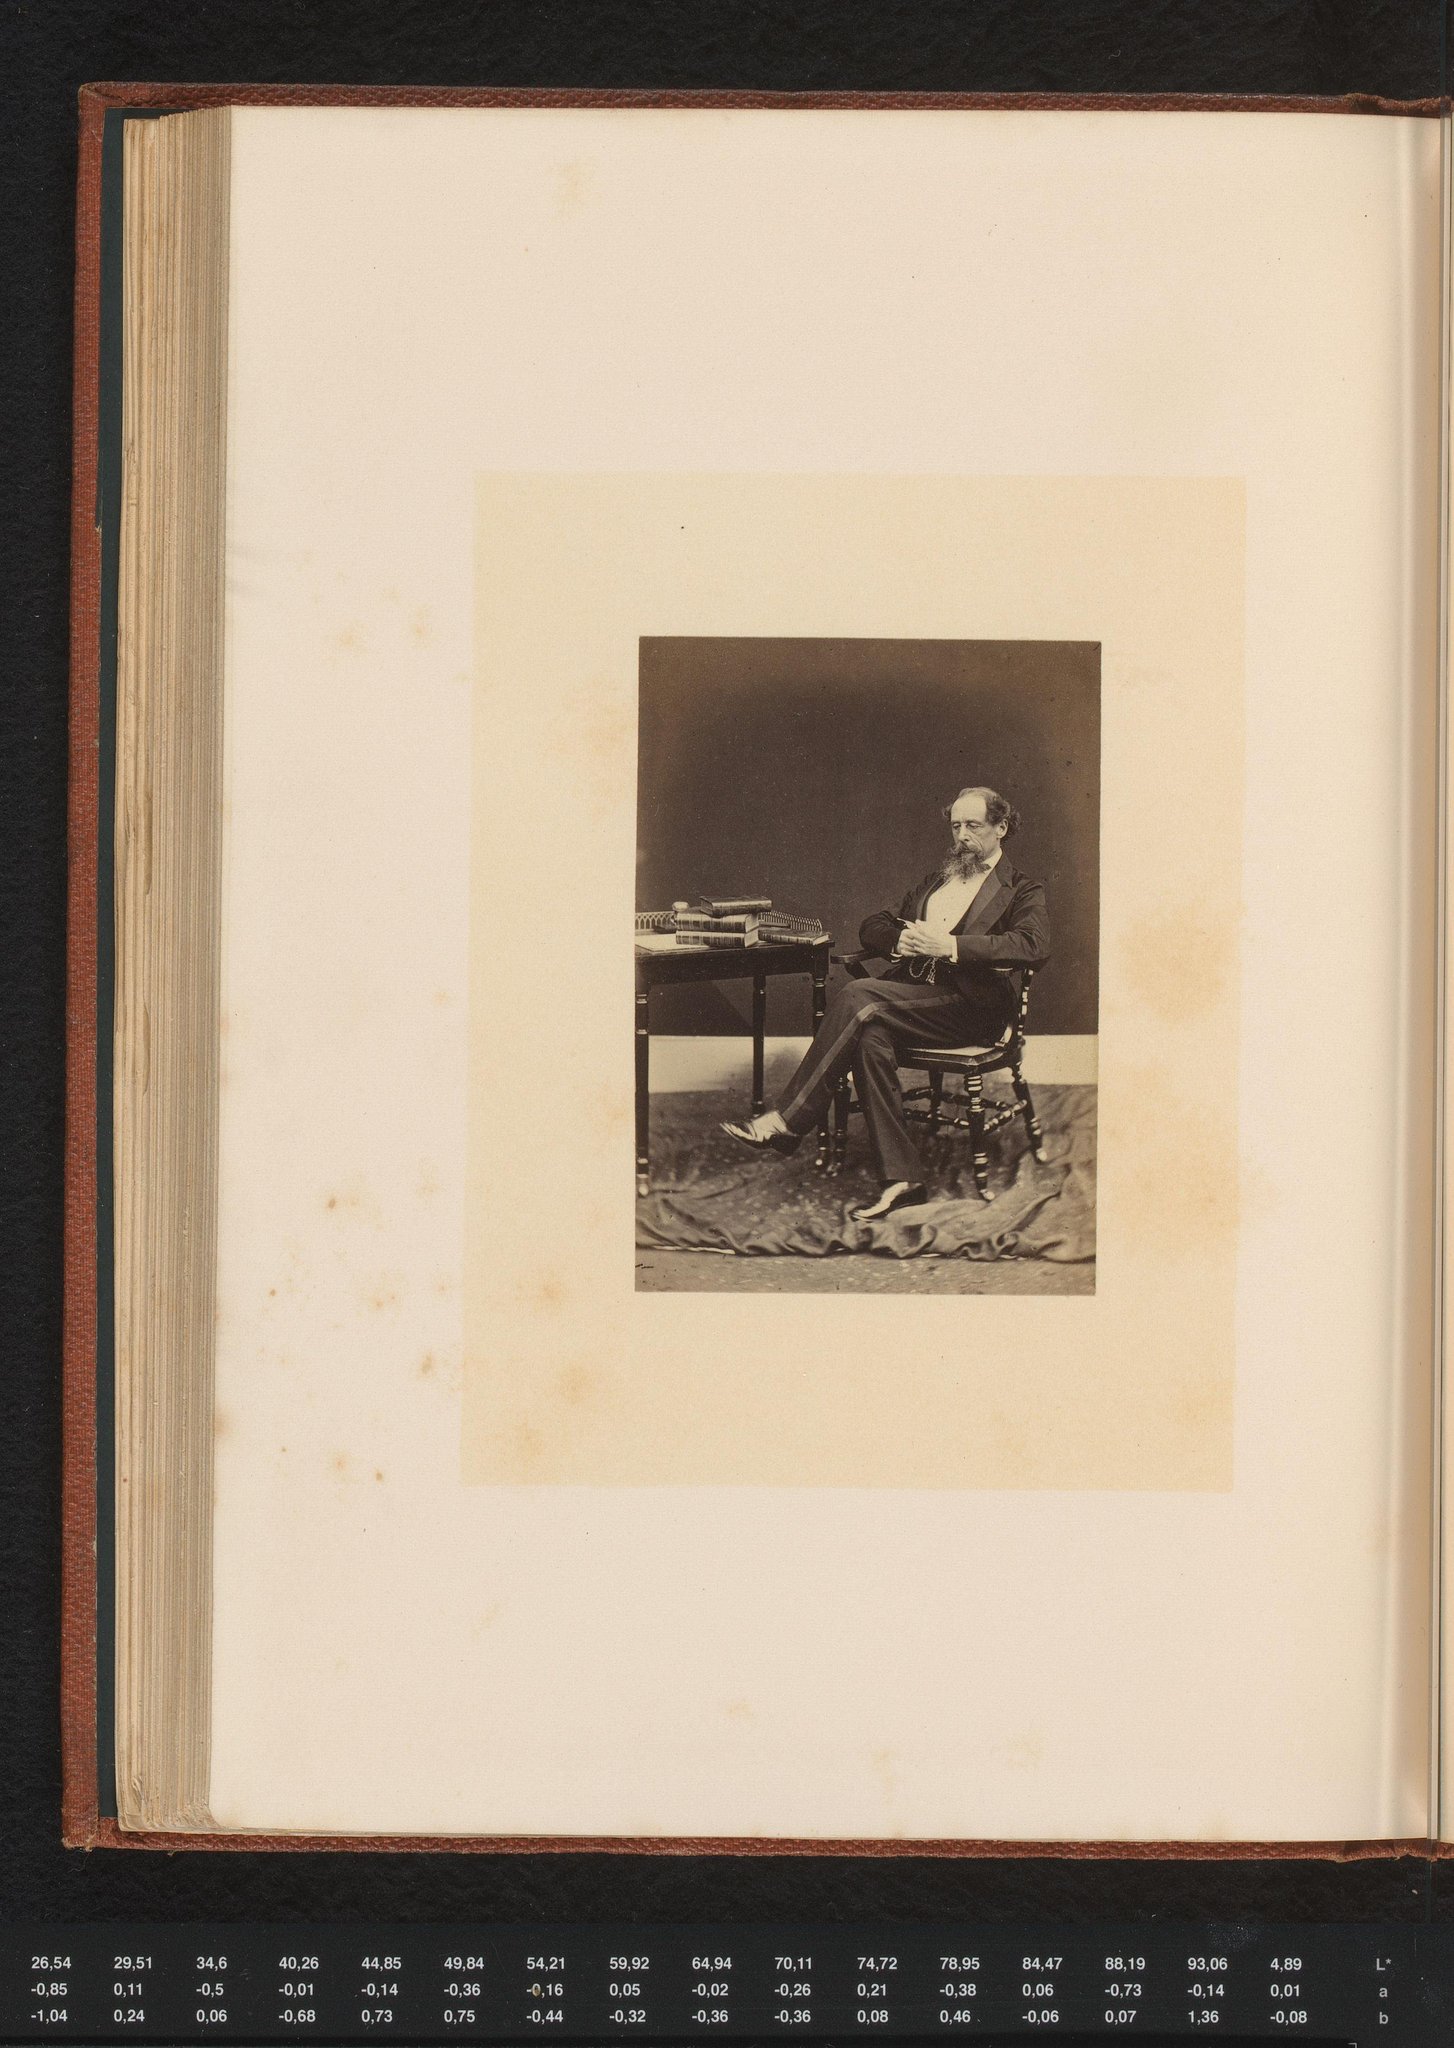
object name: photograph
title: Portret van de schrijver Charles Dickens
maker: ernest edwards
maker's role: fotograaf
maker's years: 1837-1903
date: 1861-1866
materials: paper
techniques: albumen print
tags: portsmouth, portrait of a writer